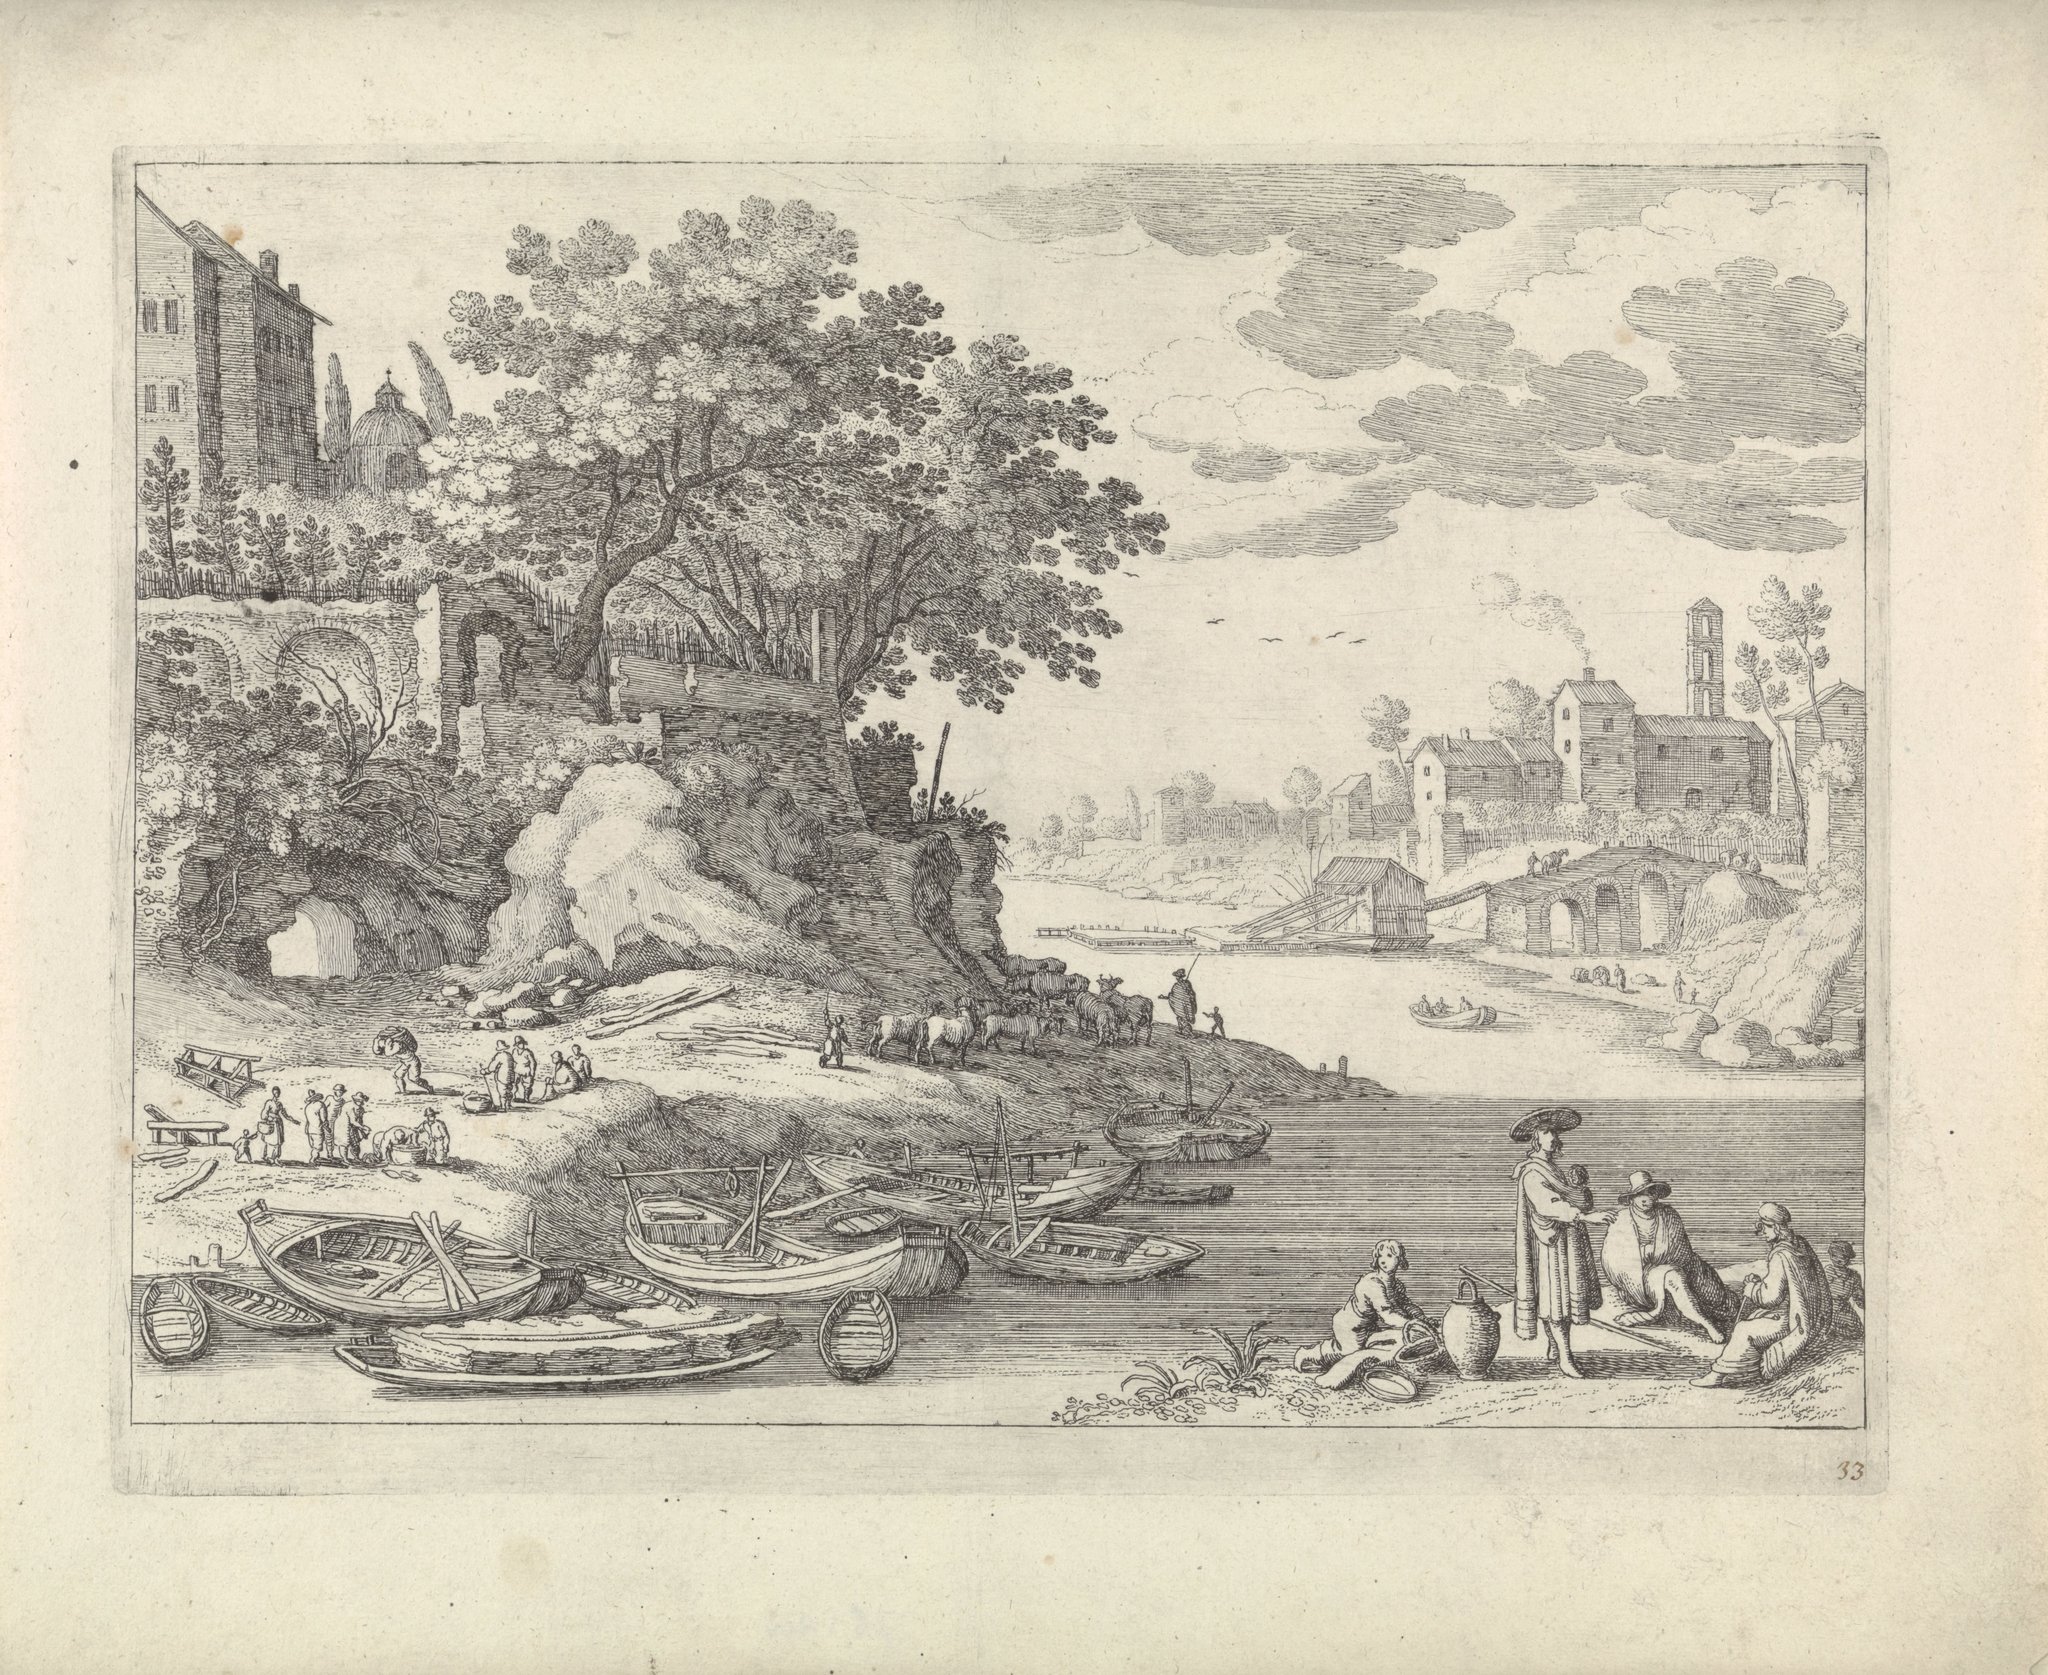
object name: print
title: Haven met roeiboten, figuren en vee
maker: guilliam van nieulandt (ii)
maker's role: draughtsman, print maker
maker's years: 1584-1635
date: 1594-1635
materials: paper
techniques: brush, engraving, etching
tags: harbour, river, rowing-boat, canoe, etc.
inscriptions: collector's mark: Lugt 2228, collector's mark: Lugt 2760, inscription: ‘33’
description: Haven aan een rivier met aangemeerde roeiboten. Op de linkeroever verschillende figuren en een kudde vee. Op de rechteroever staat een vrouw met een kind in een draagdoek bij enkele zittende figuren.